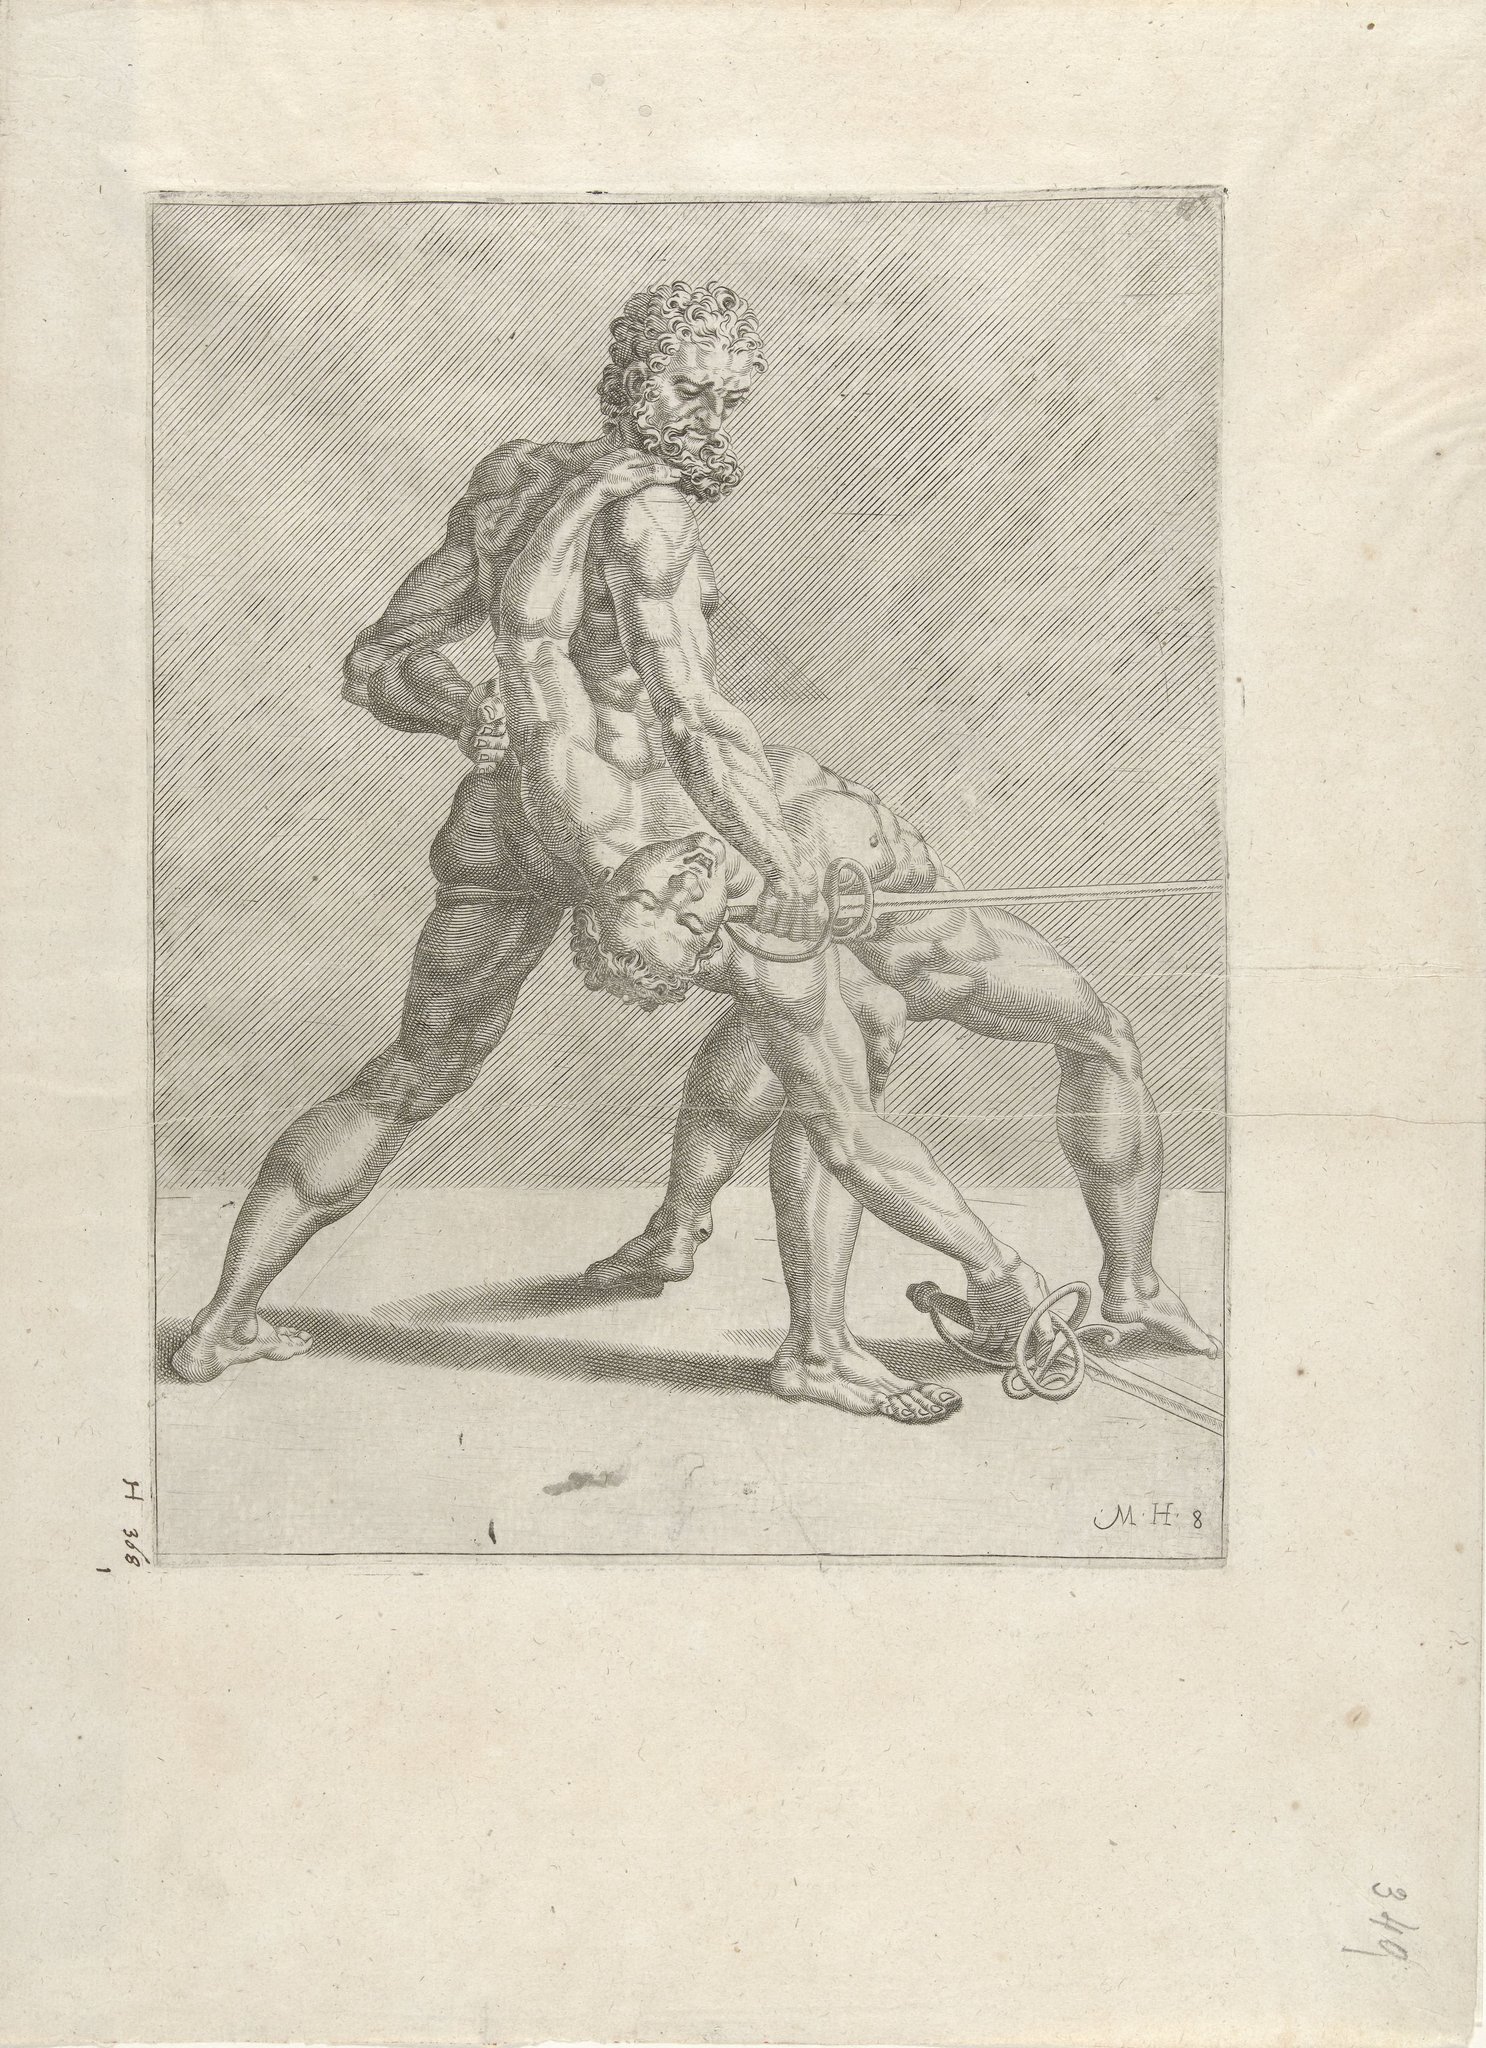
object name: print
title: Zwaardvechters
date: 1552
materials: paper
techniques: engraving, etching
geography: groningen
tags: athletics, gymnastics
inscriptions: collector's mark: Lugt 2228, number: ‘H.368’, collector's mark: Lugt 2760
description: Twee naakte zwaardvechters. De prent maakt deel uit van een serie over twee zwaardvechters in een tweekamp.